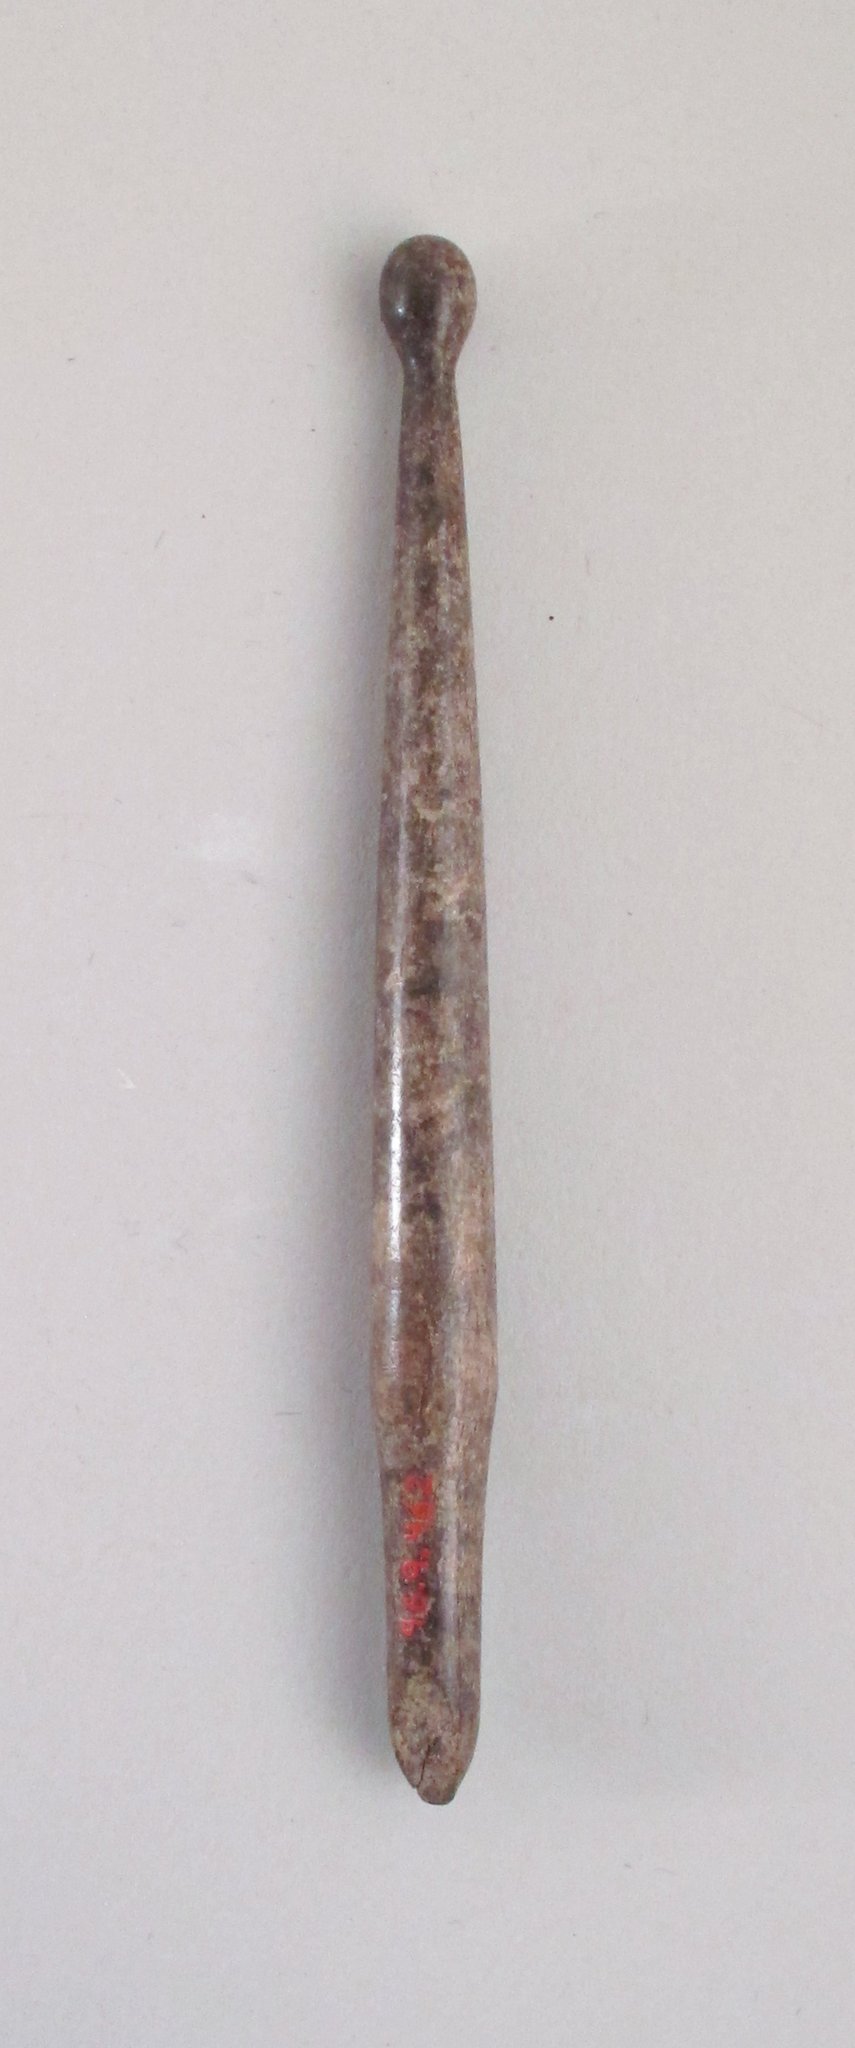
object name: stylus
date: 7000 BCE-330 CE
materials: bone, ivory